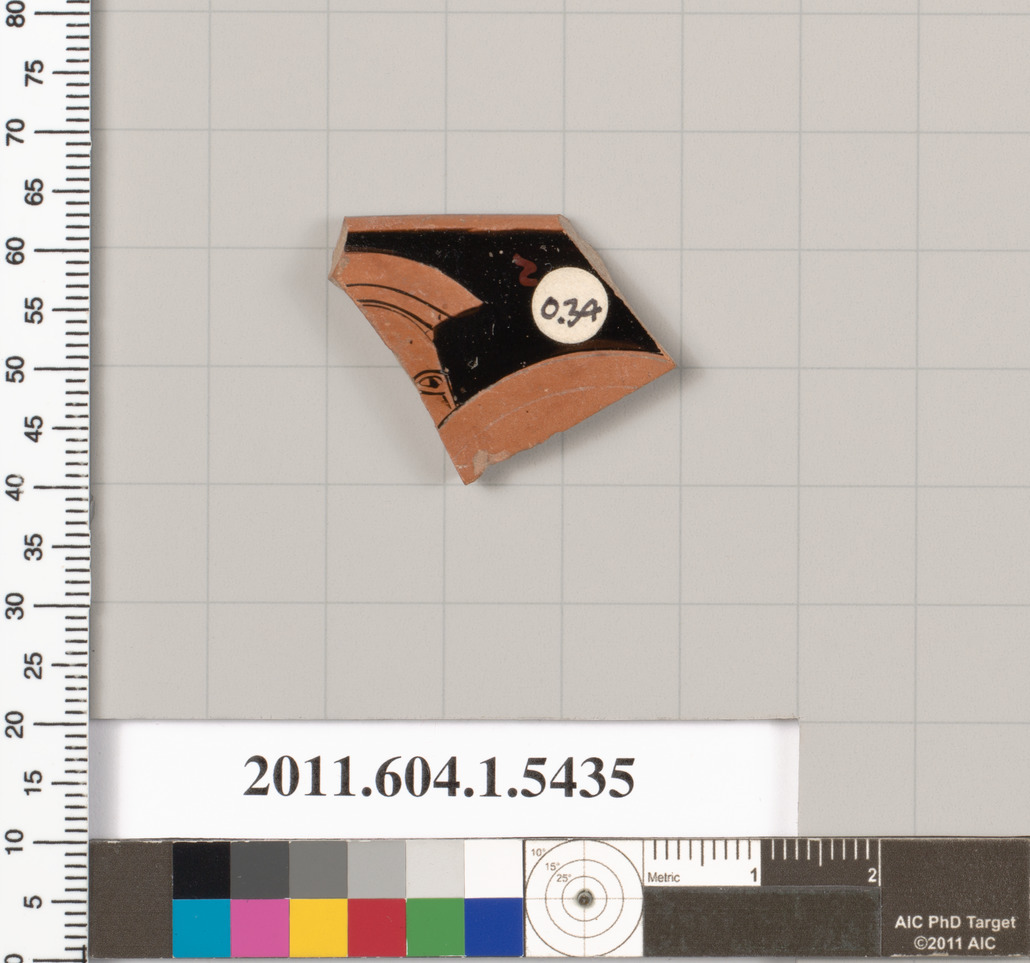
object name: kylix fragment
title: Terracotta rim fragment of a kylix (drinking cup)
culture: greek, attic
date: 500-480 BCE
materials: terracotta